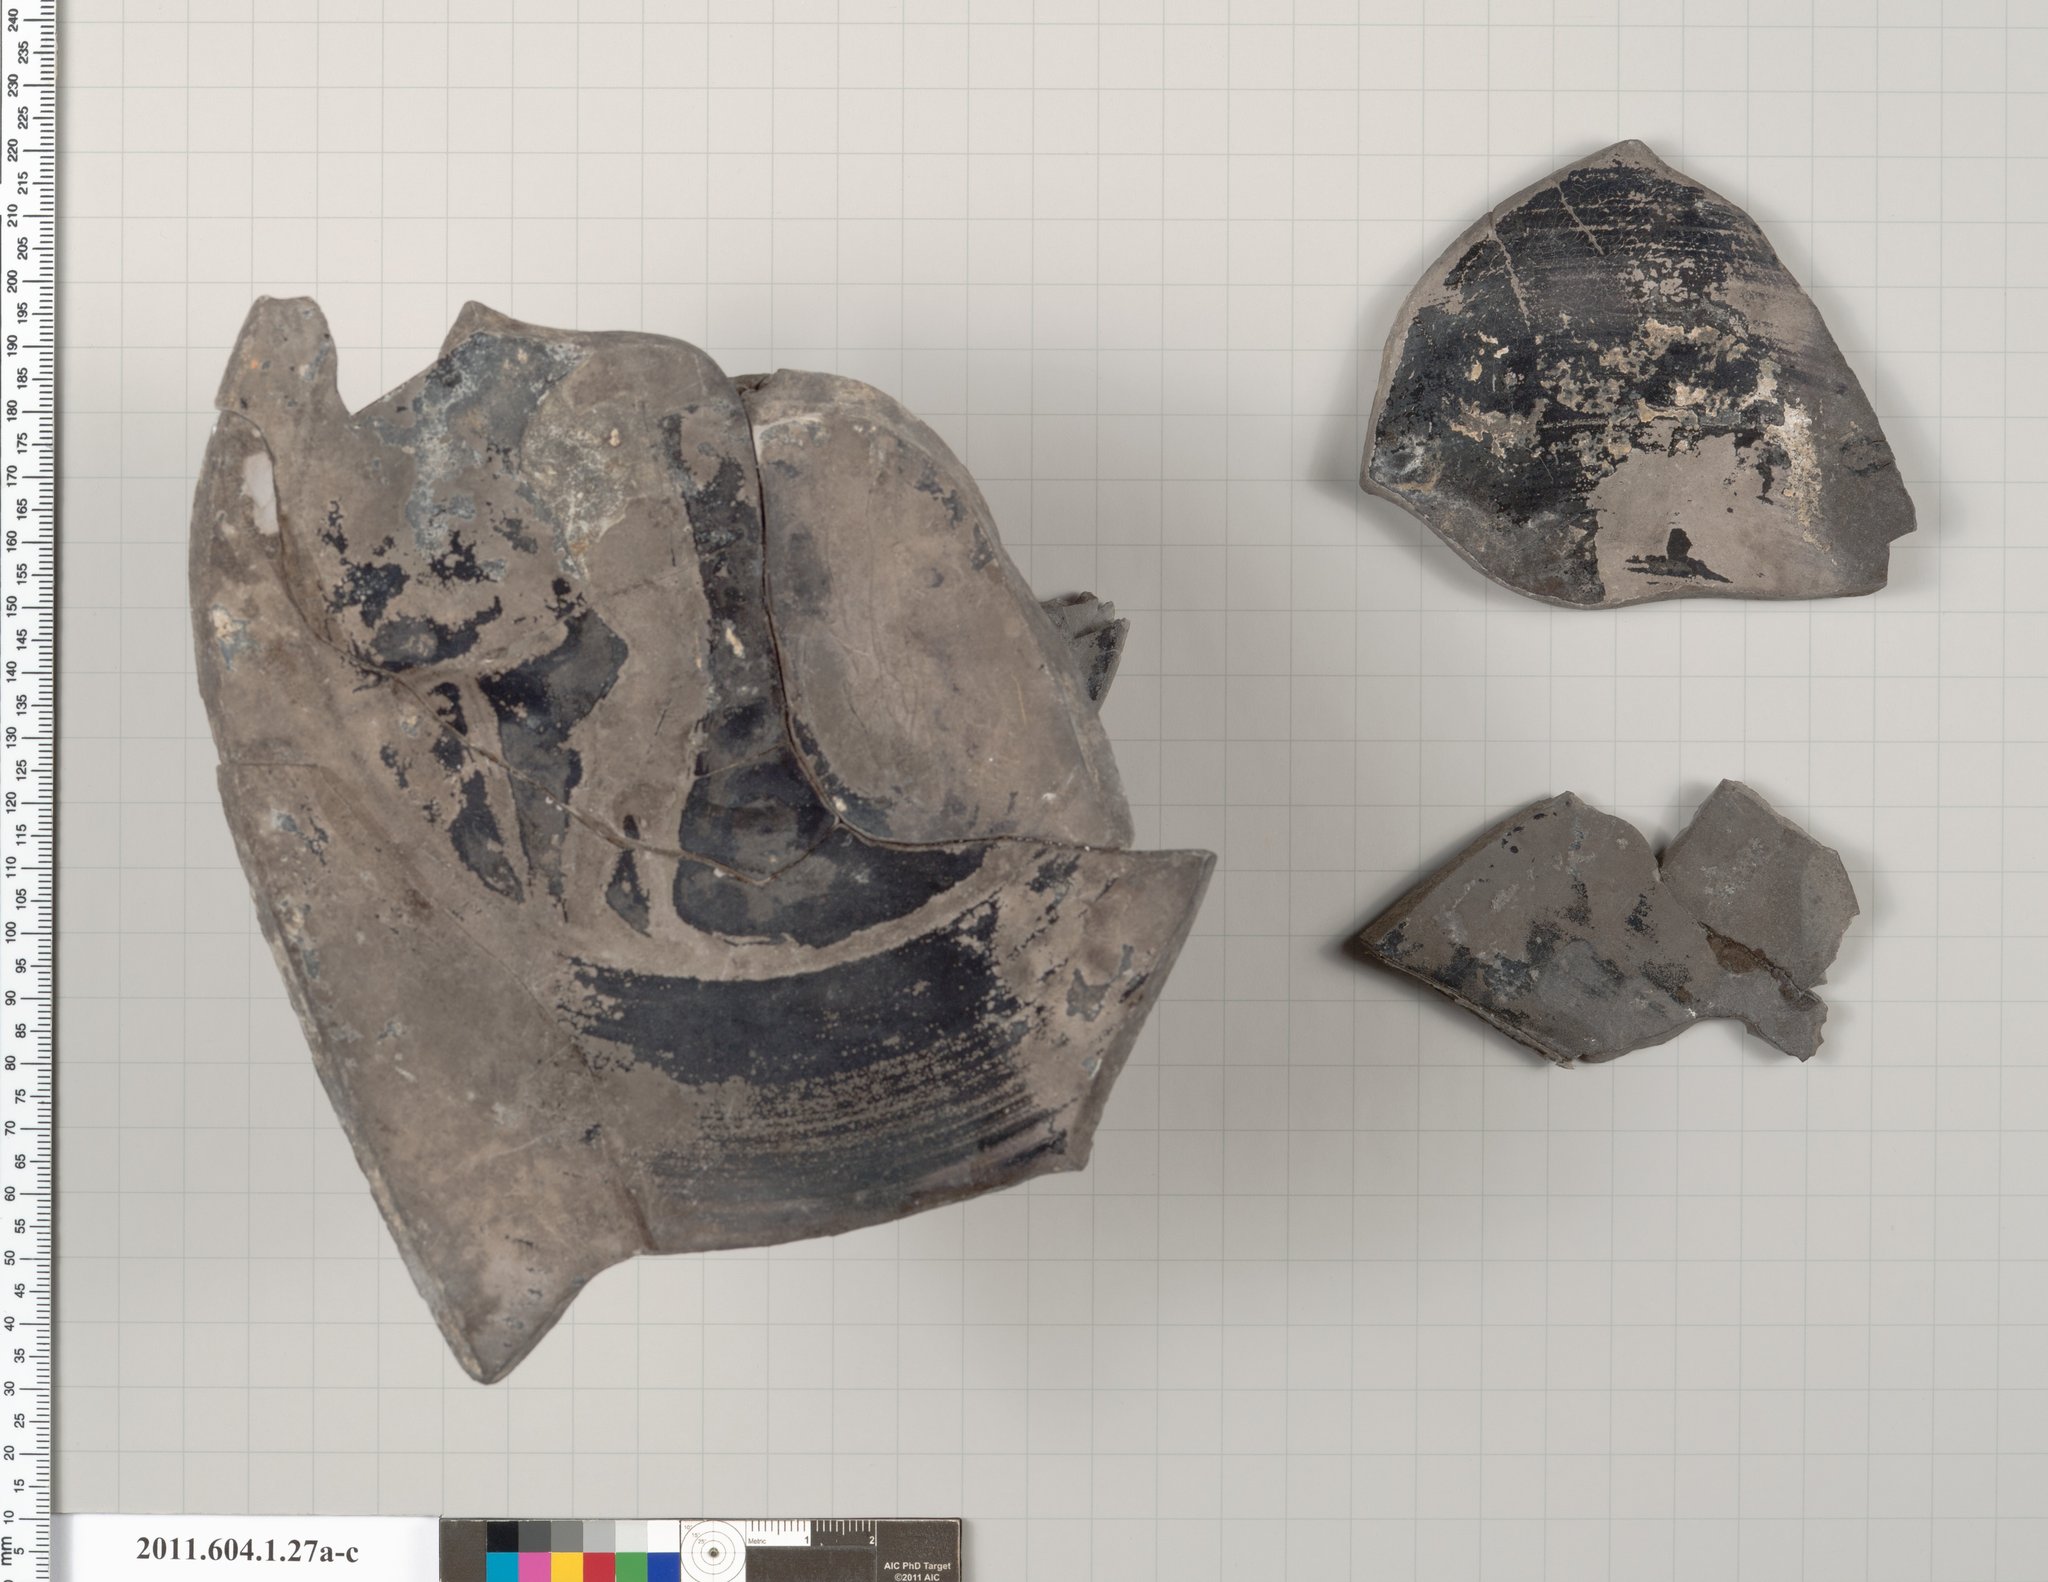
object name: kylix fragment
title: Terracotta fragments of a kylix (drinking cup)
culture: greek, attic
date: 534-501 BCE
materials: terracotta